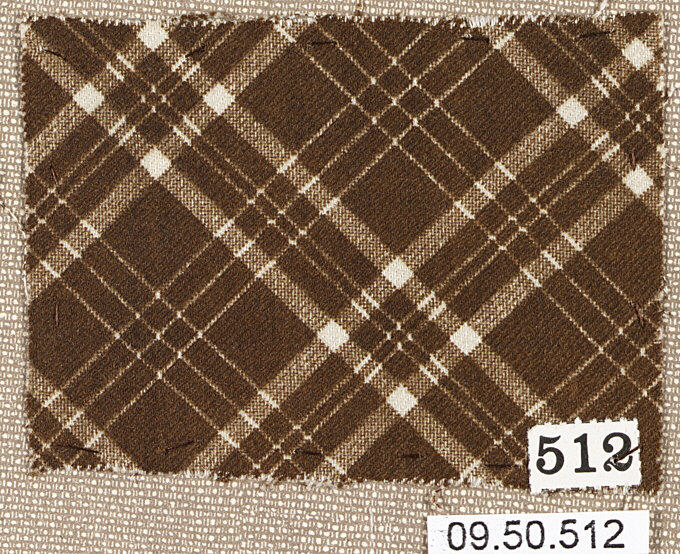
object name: piece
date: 1801-1900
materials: cotton